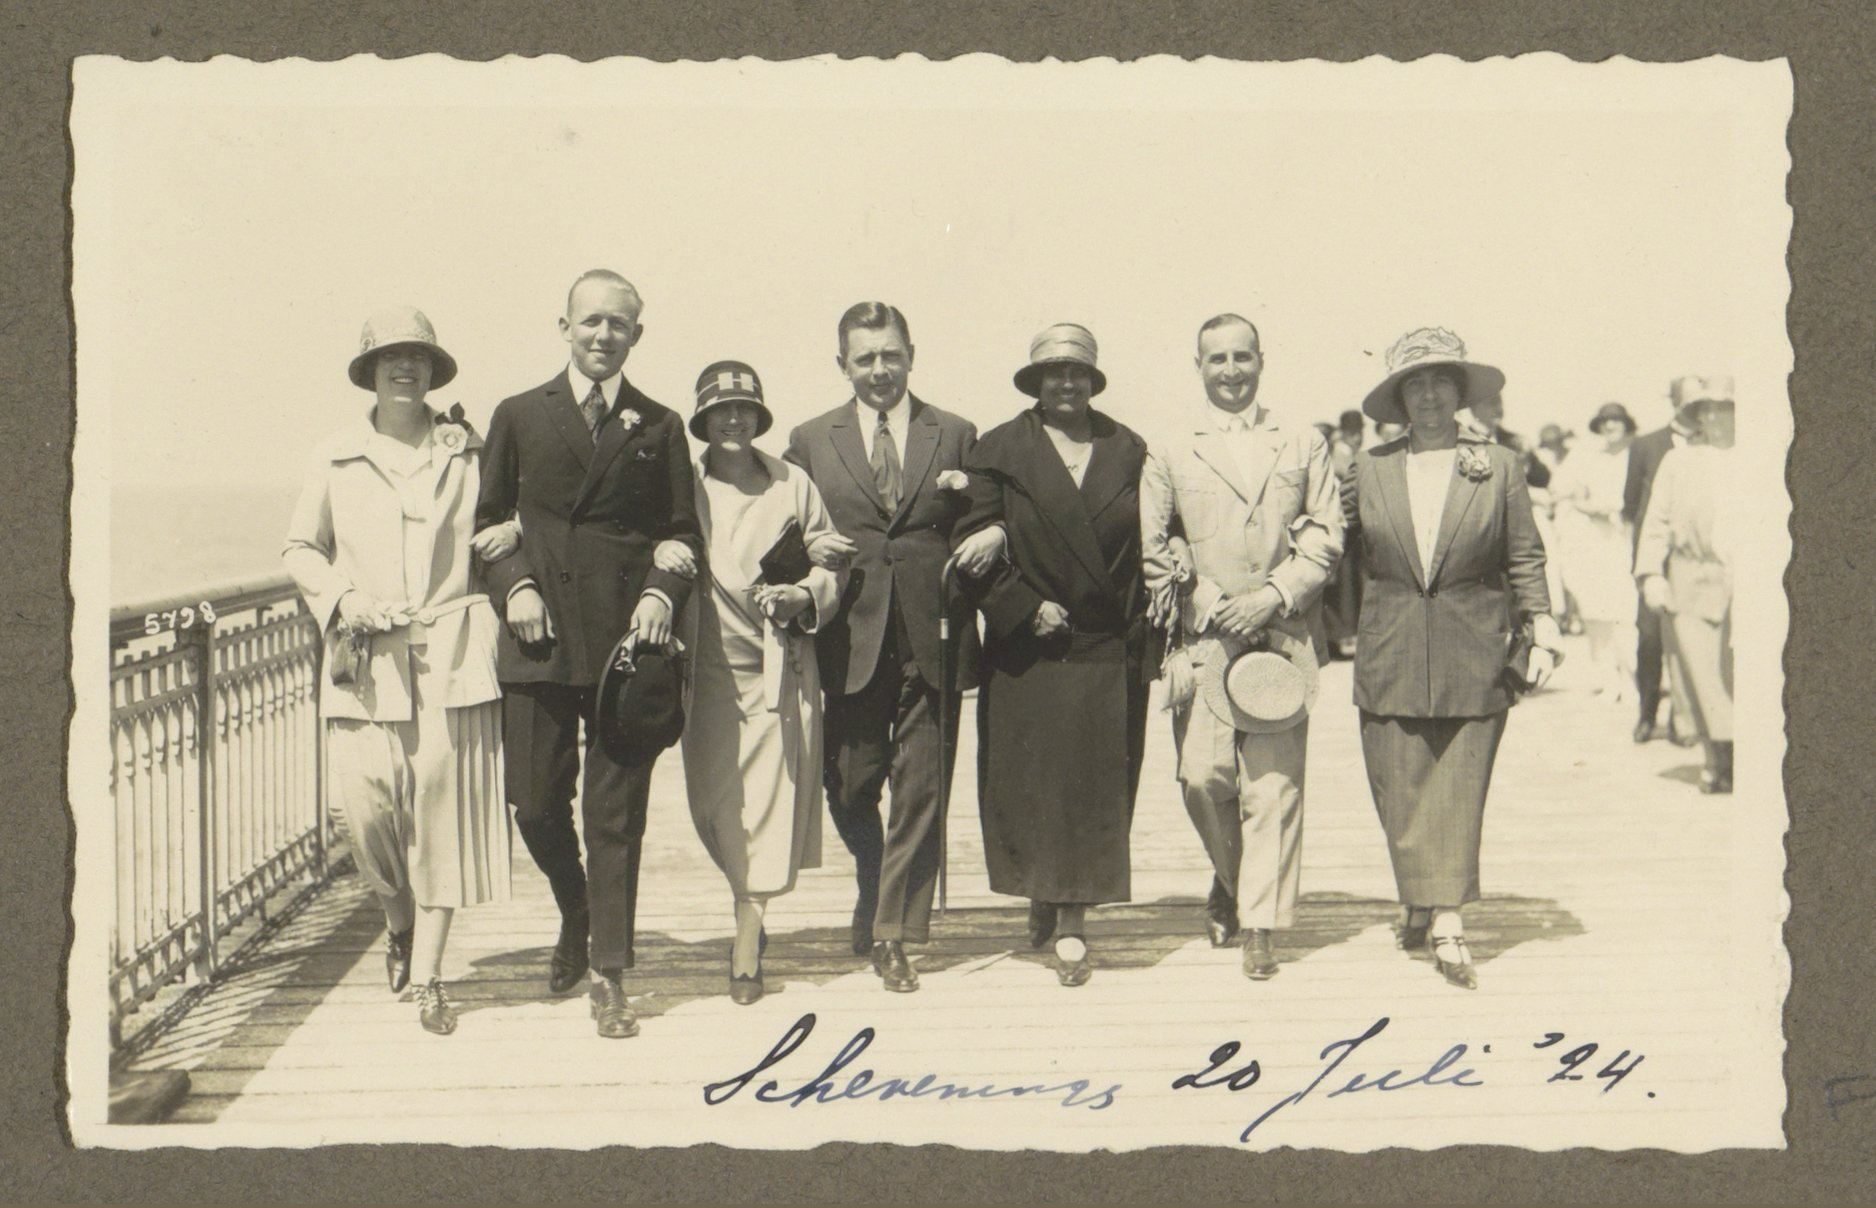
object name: photograph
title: Gezelschap wandelend over (vermoedelijk) de pier van Scheveningen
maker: Anonymous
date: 1924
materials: photographic support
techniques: gelatin silver print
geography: scheveningen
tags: adult woman, strolling, adult man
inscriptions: number: ‘5798’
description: Onderdeel van fotoalbum van een onbekende Nederlandse familie met opnames van Suriname, Europa en Nederlands-Indië.